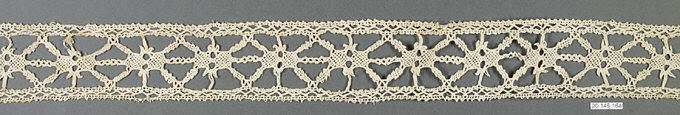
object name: fragment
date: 1501-1600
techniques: lace